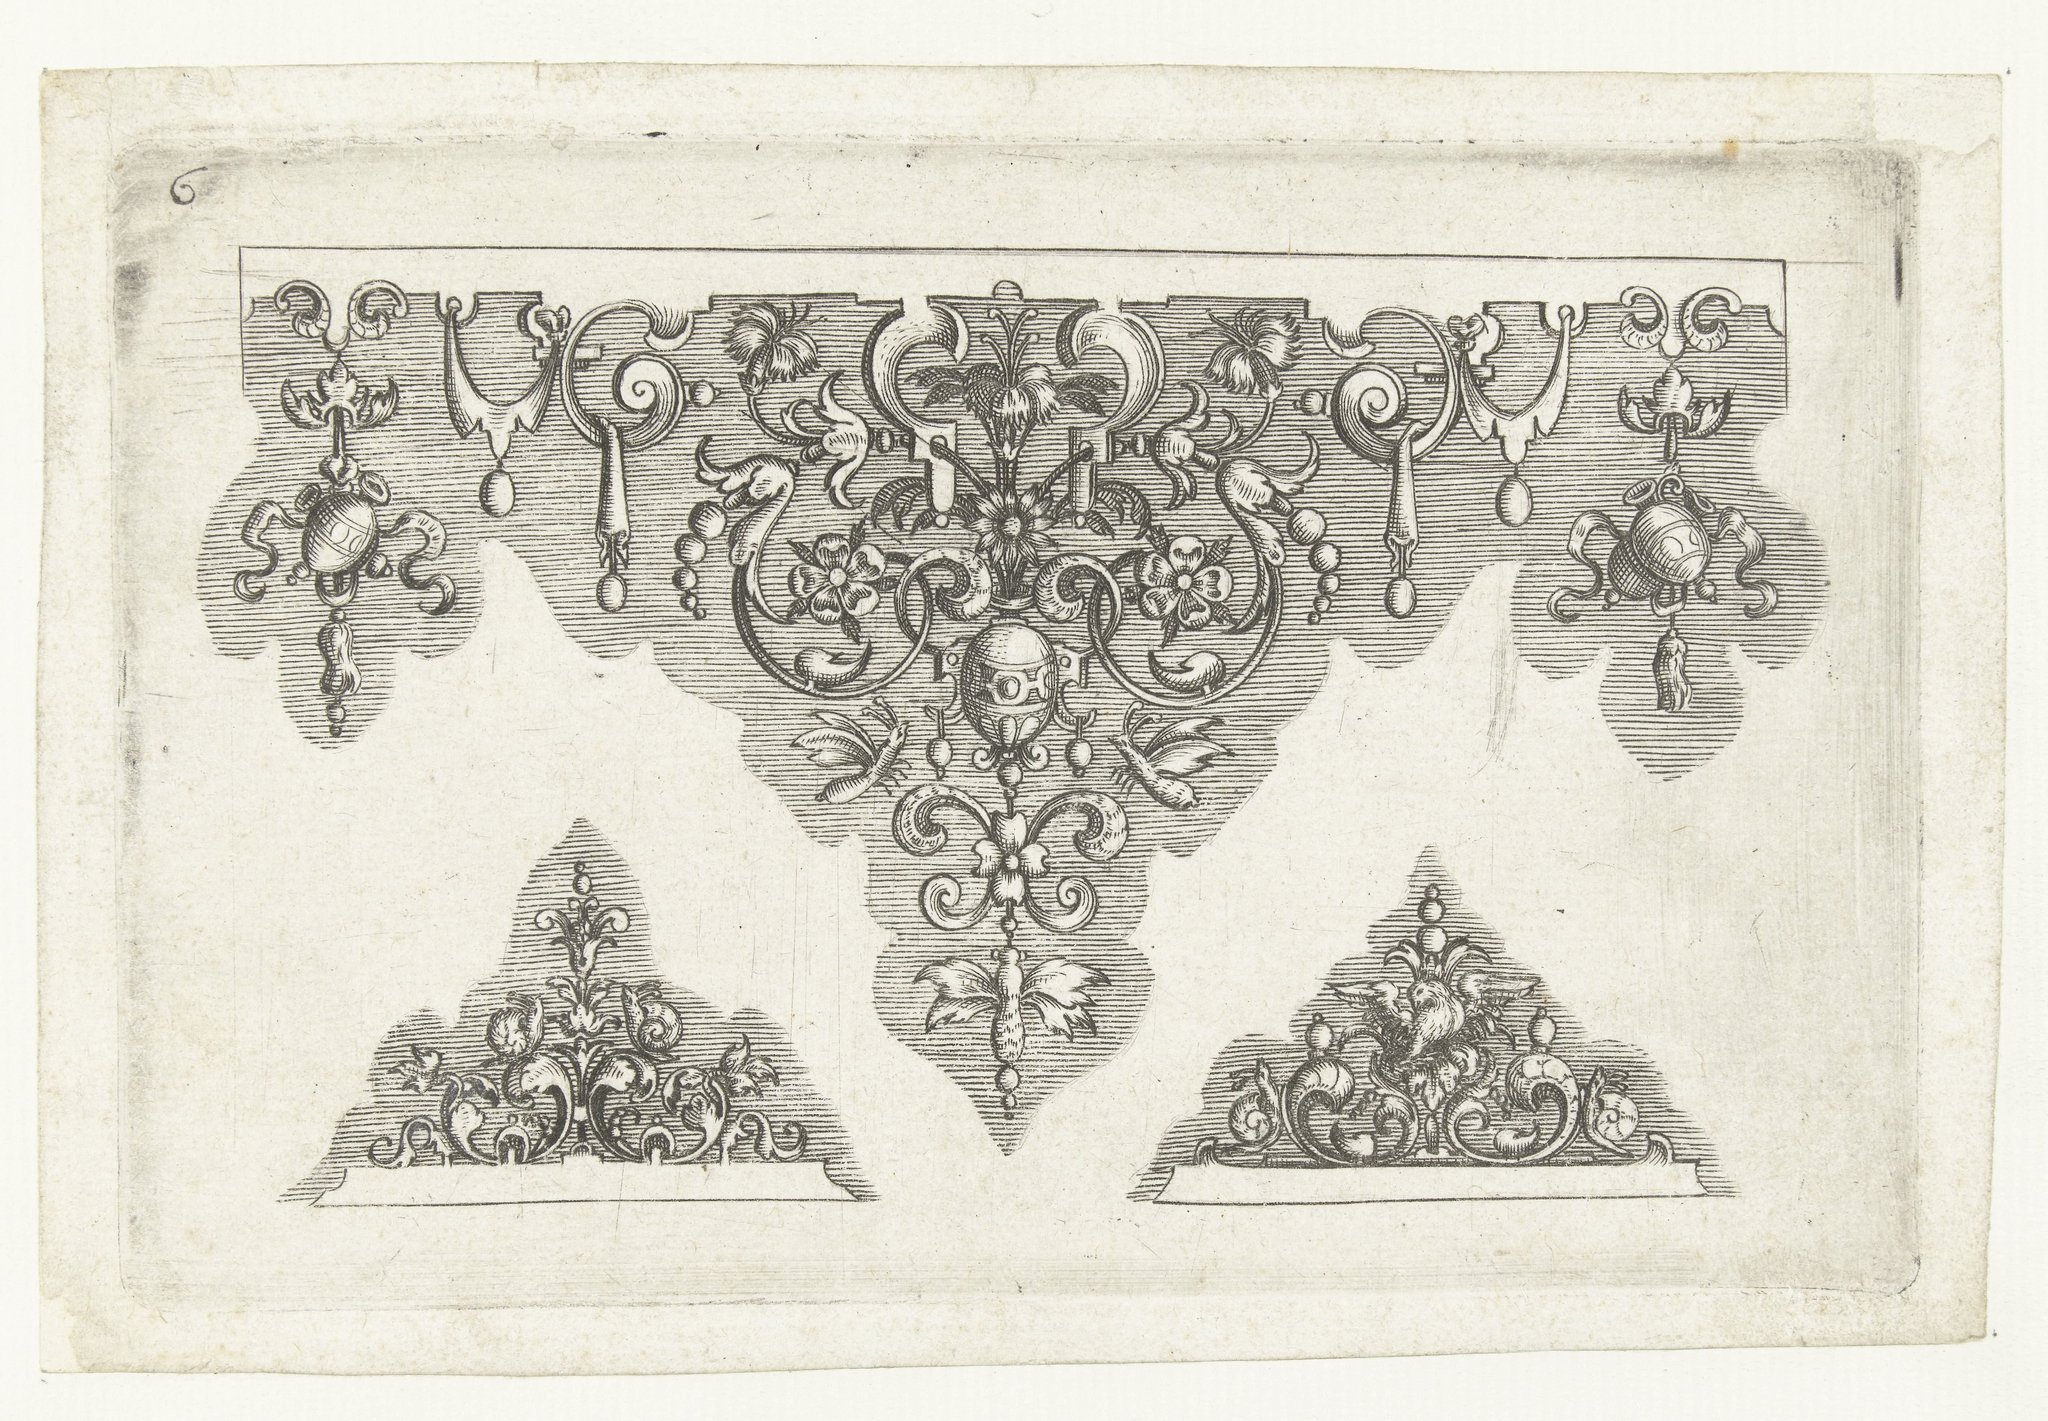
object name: ornament print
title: Ornamenten voor goudsmidswerk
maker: Anonymous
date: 1571-1639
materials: paper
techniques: engraving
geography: germany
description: In het midden een vaas met bloemen tussen twee insecten. Eén van 6 deels genummerde bladen. Tegenzijdige kopieën naar de prenten van de onder Orn Cat I-317 beschreven serie.